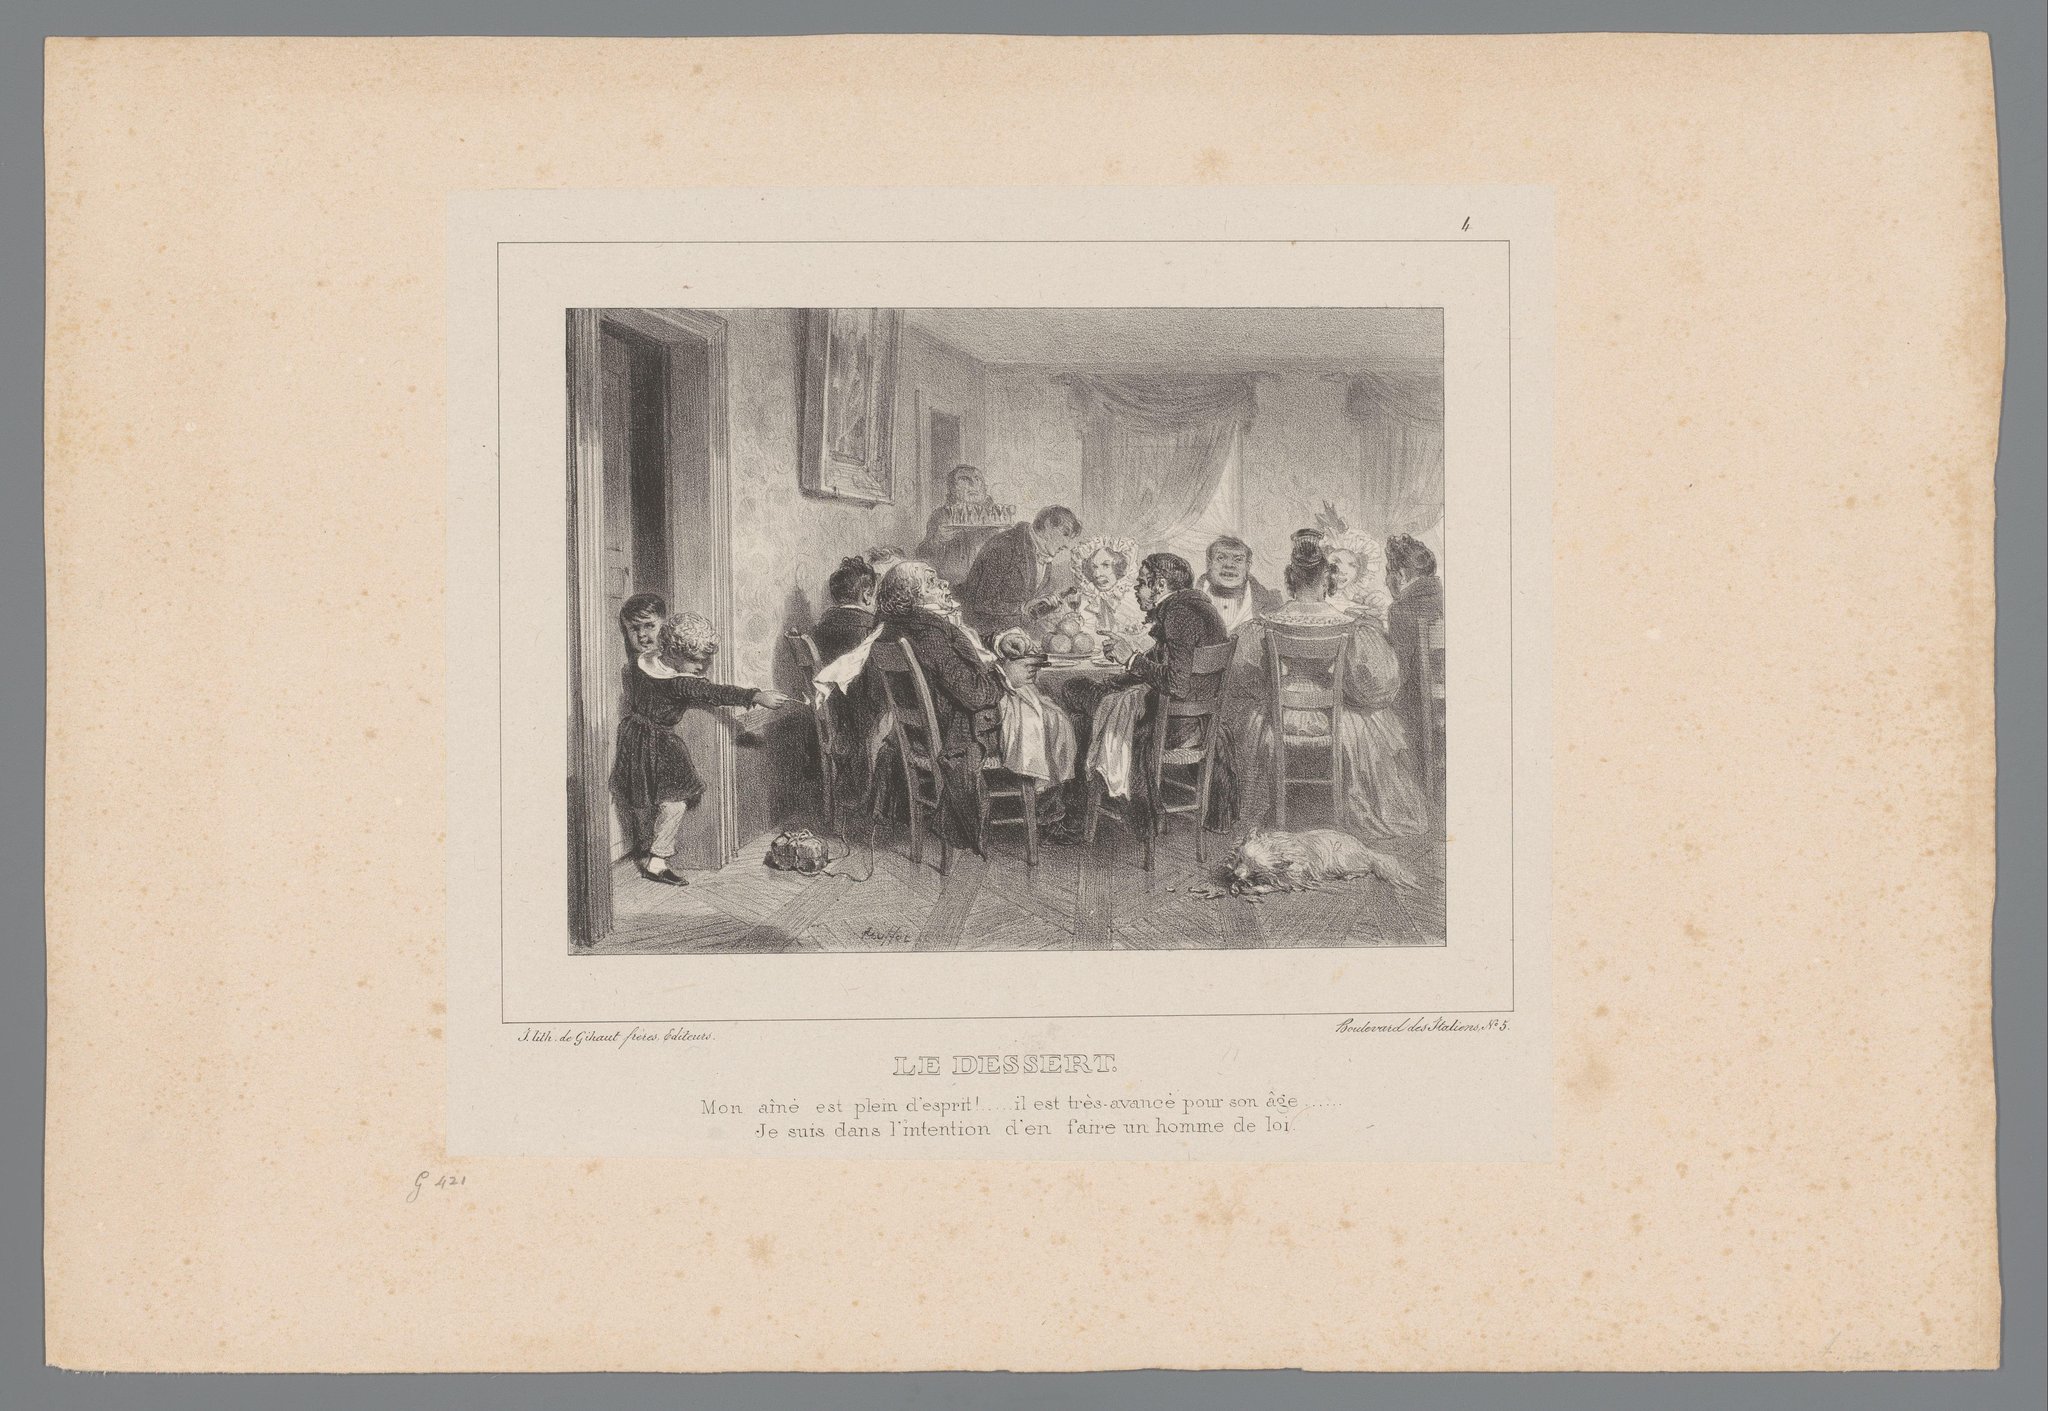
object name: print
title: Volwassenen aan tafel terwijl twee kinderen kattekwaad uithalen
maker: denis auguste marie raffet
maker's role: draughtsman, print maker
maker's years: 1804-1860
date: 1837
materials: paper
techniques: lithograph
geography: paris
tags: mischief-making play, adult woman, adult man, child, evening meal, dinner, supper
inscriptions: collector's mark: Lugt 964